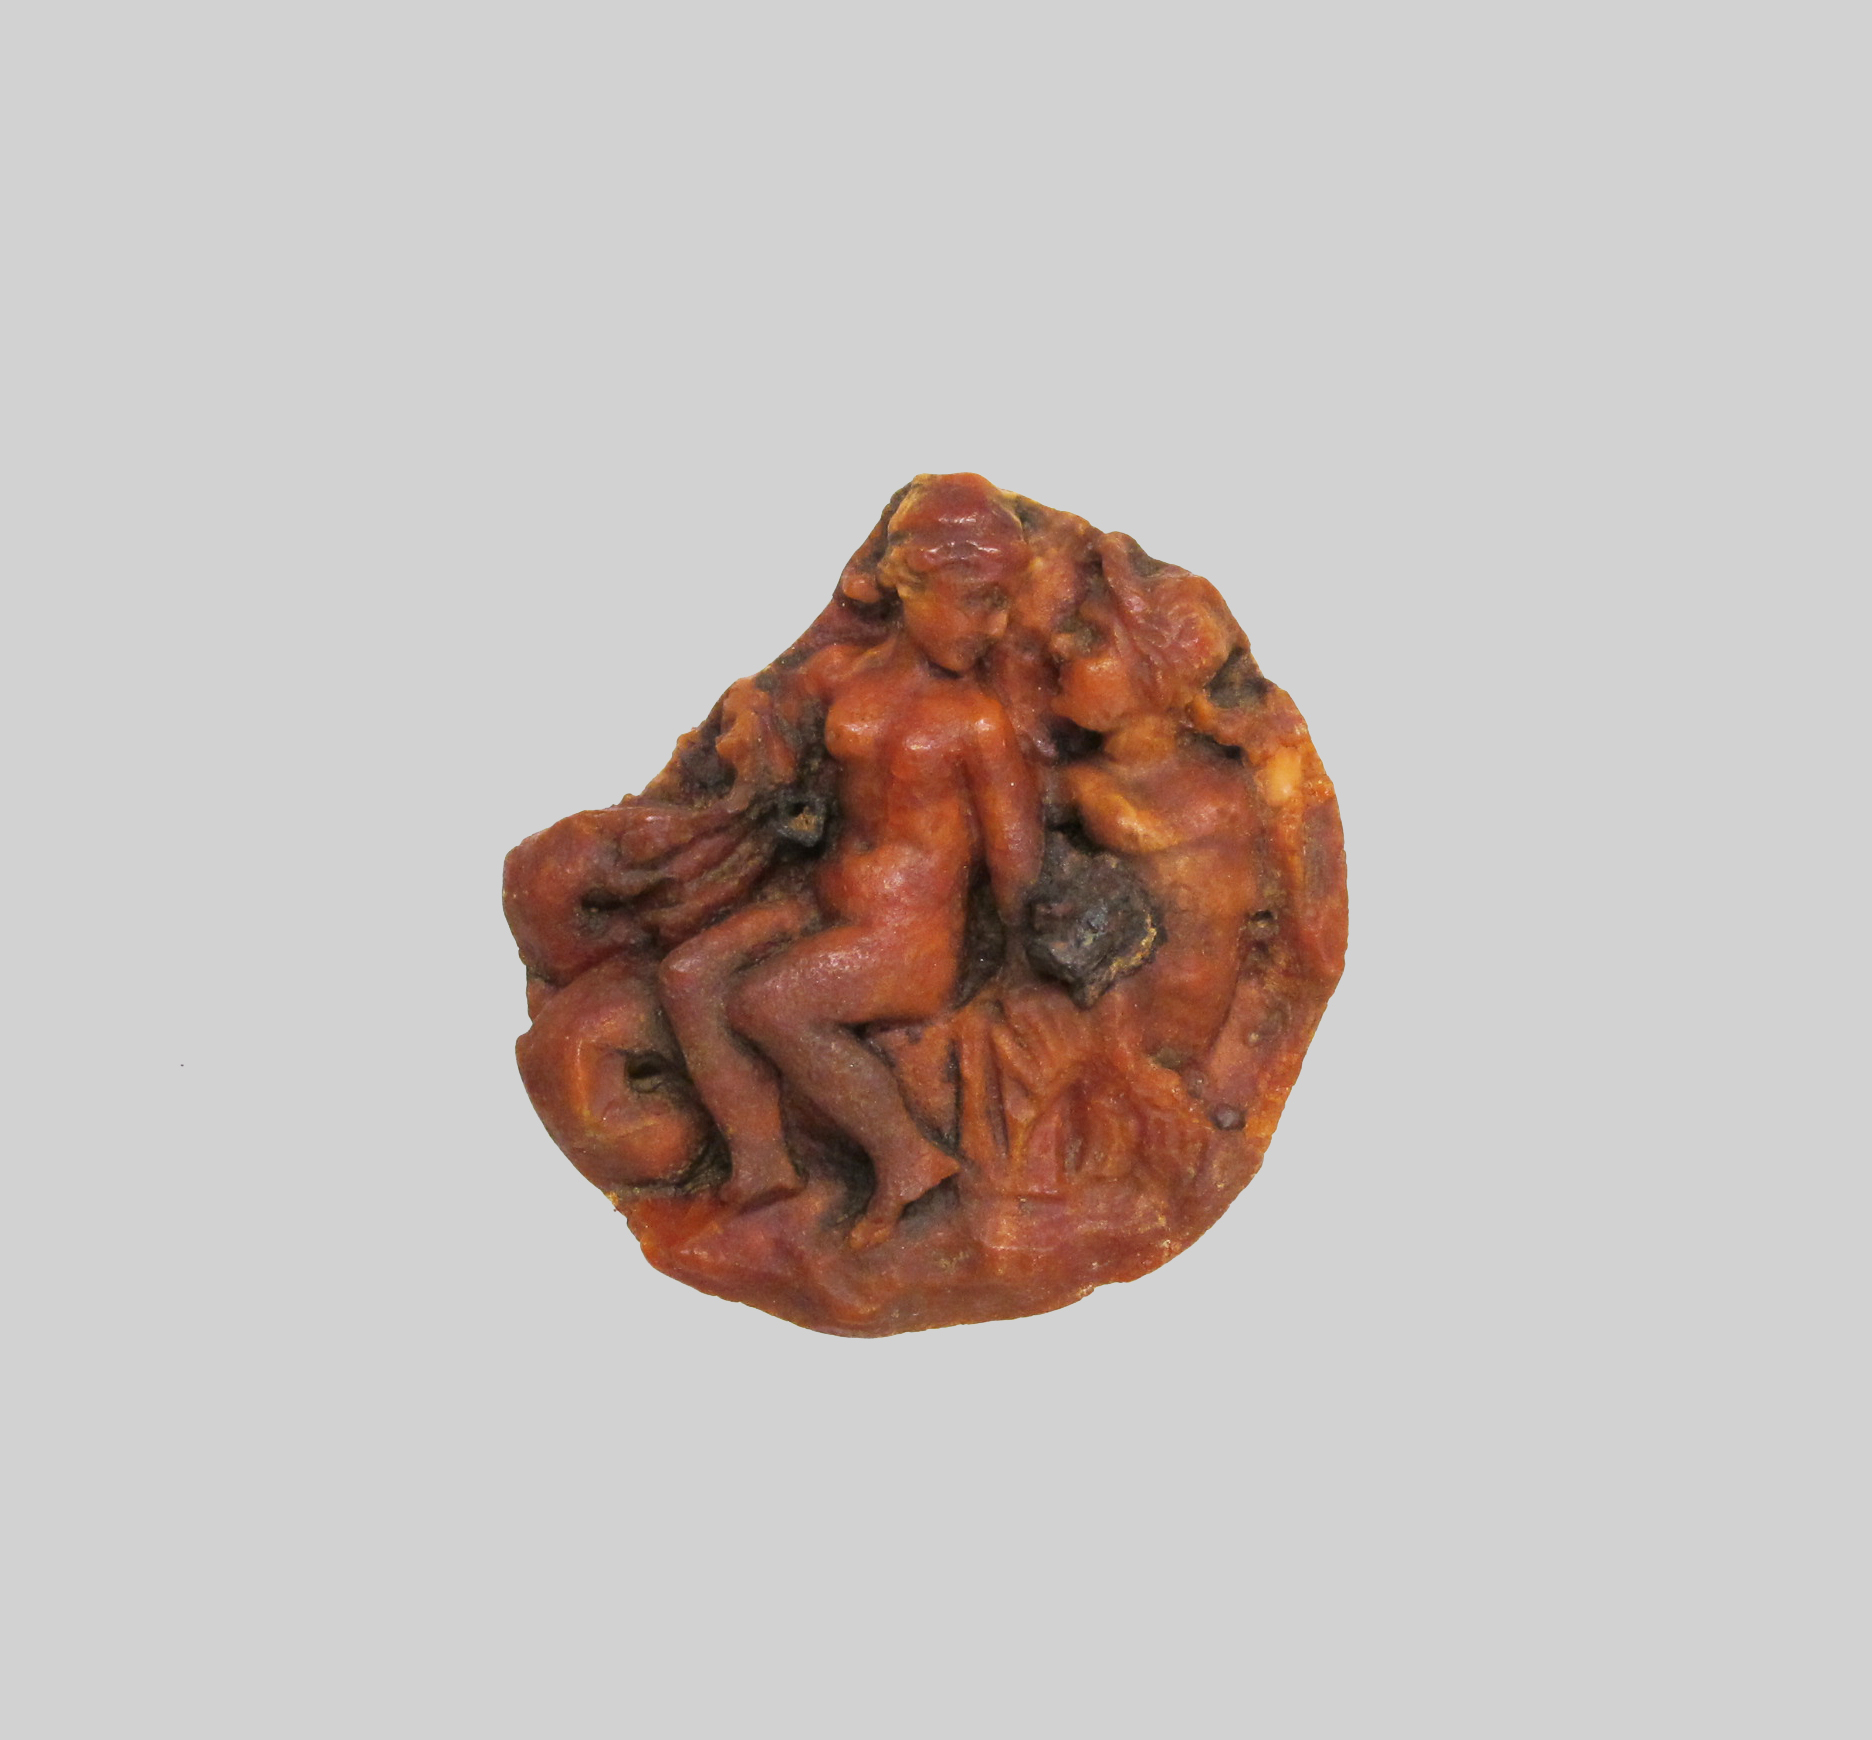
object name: disk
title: Amber disk with a nereid riding a triton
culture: roman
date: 1-133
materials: amber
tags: triton